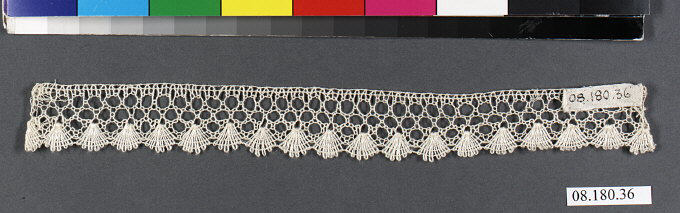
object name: fragment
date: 1801-1900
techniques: lace